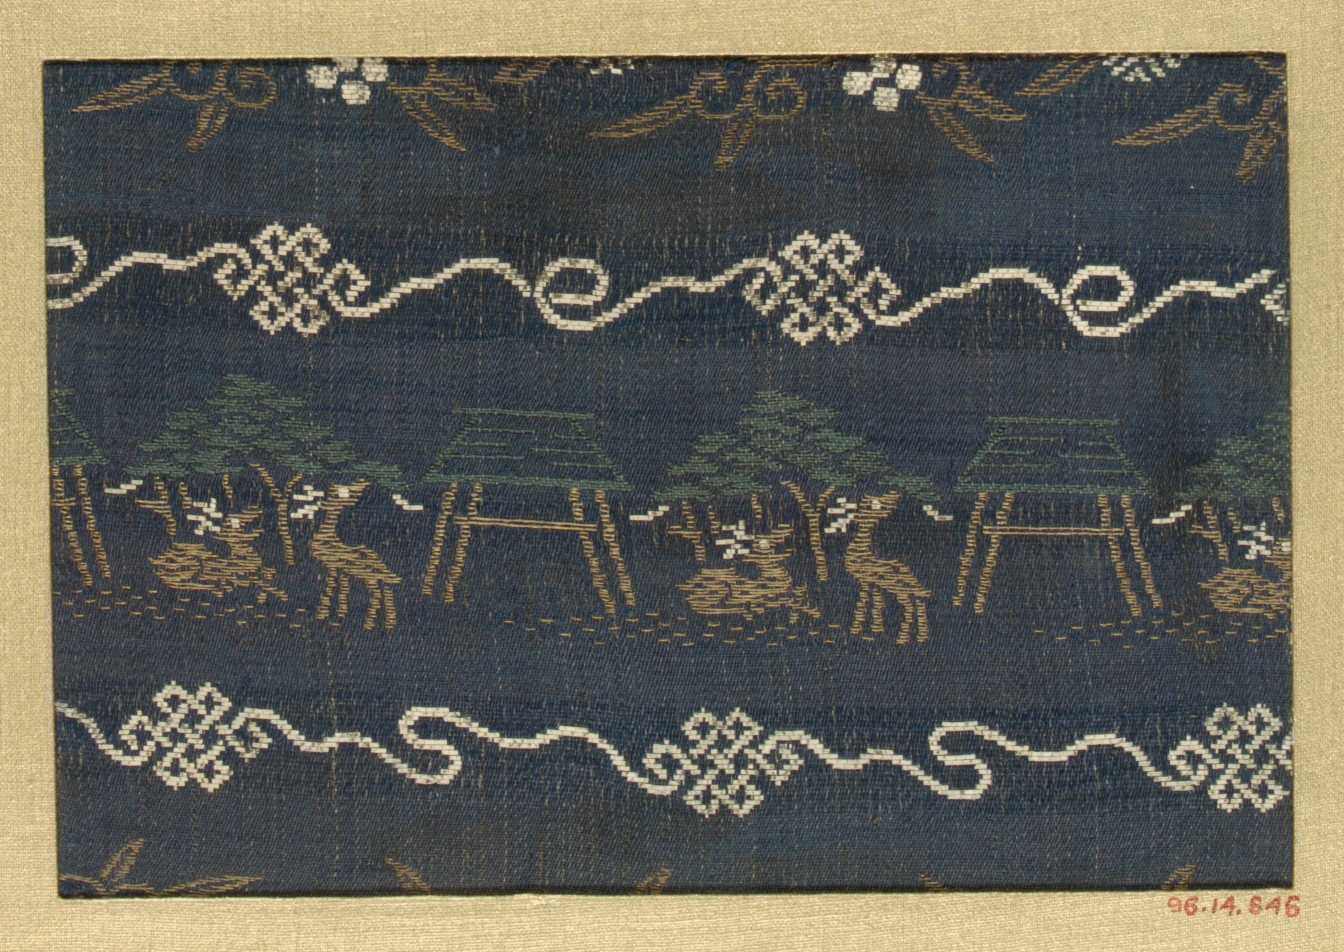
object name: piece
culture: japanese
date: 1701-1900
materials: silk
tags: deer